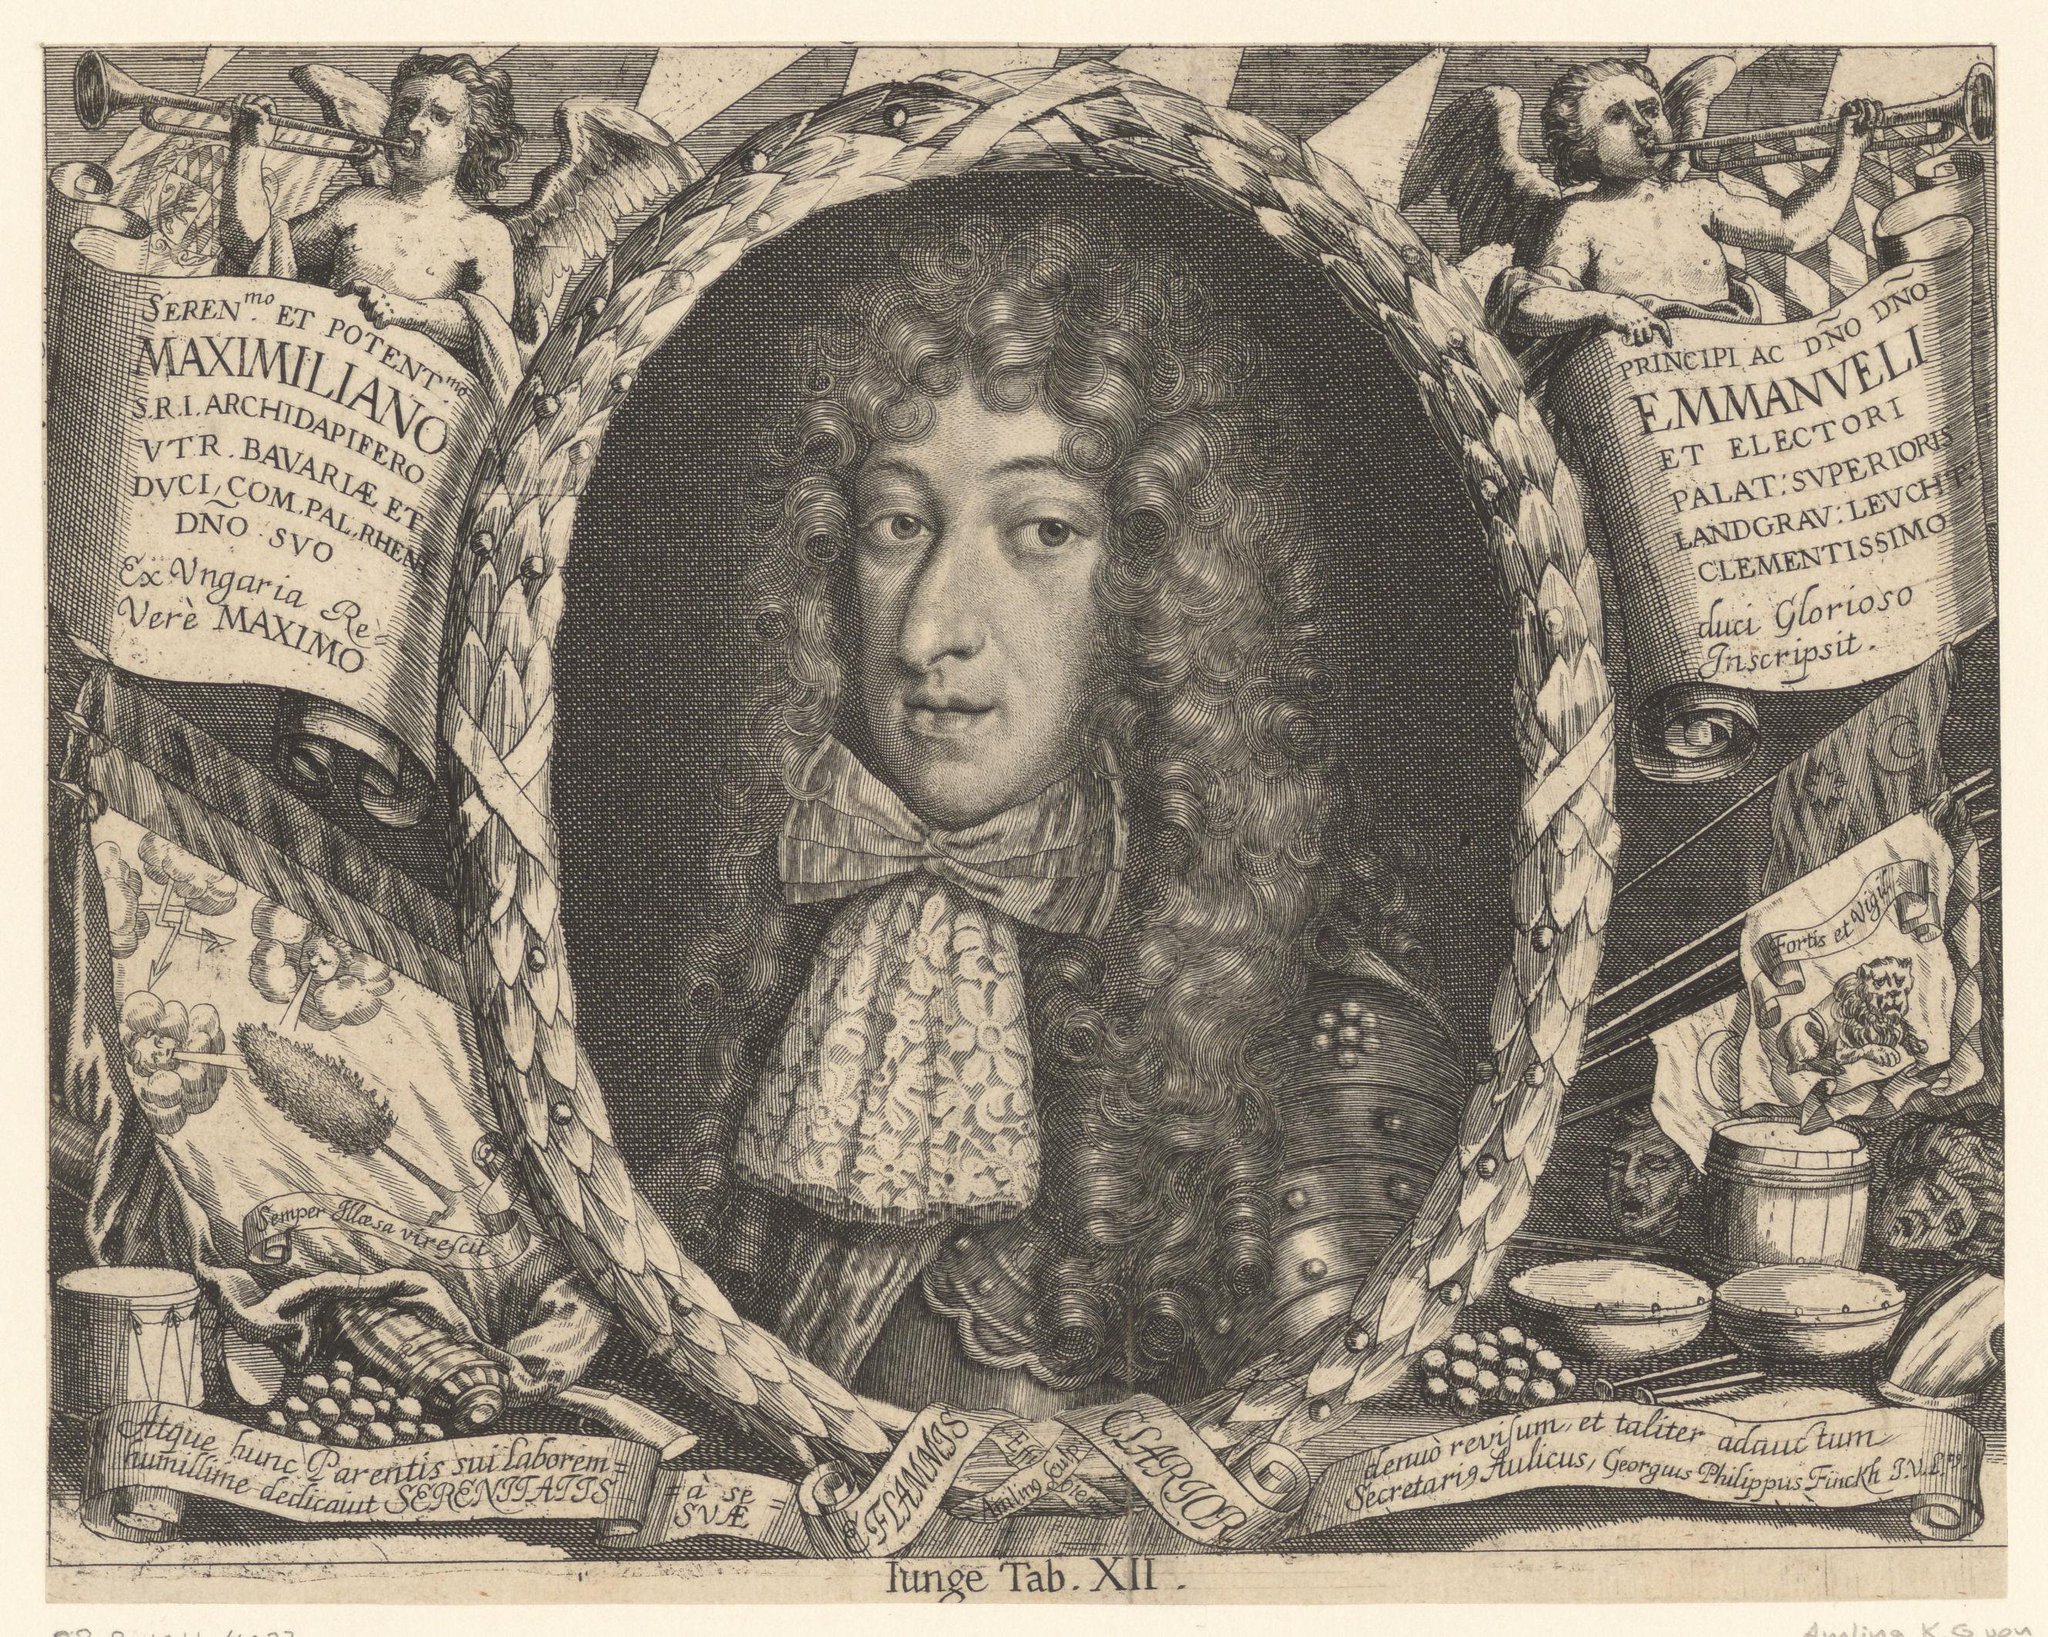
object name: print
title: Portret van Maximiliaan II Emanuel van Beieren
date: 1661-1702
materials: paper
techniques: engraving, etching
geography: munich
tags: maximiliaan ii emanuel (keurvorst van beieren), historical persons, firearms: cannon, flag, colours (as symbol of the state, etc.)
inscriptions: collector's mark: Lugt 2228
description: Volgens het opschrift is alleen het portret gegraveerd door Karl Gustav Amling.